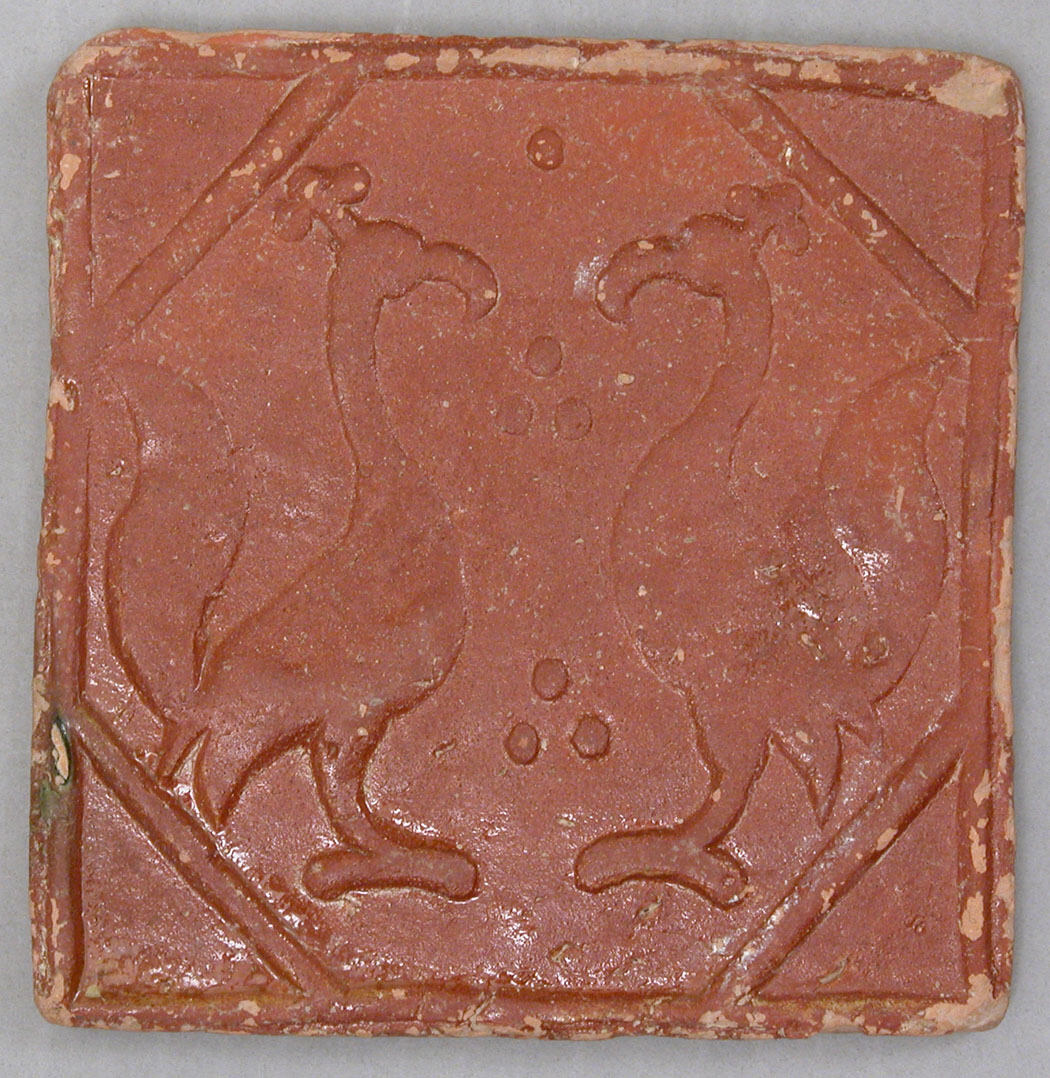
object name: tile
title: Square Tile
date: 1201-1233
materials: stonepaste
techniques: glazing, molding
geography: afghanistan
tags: animals